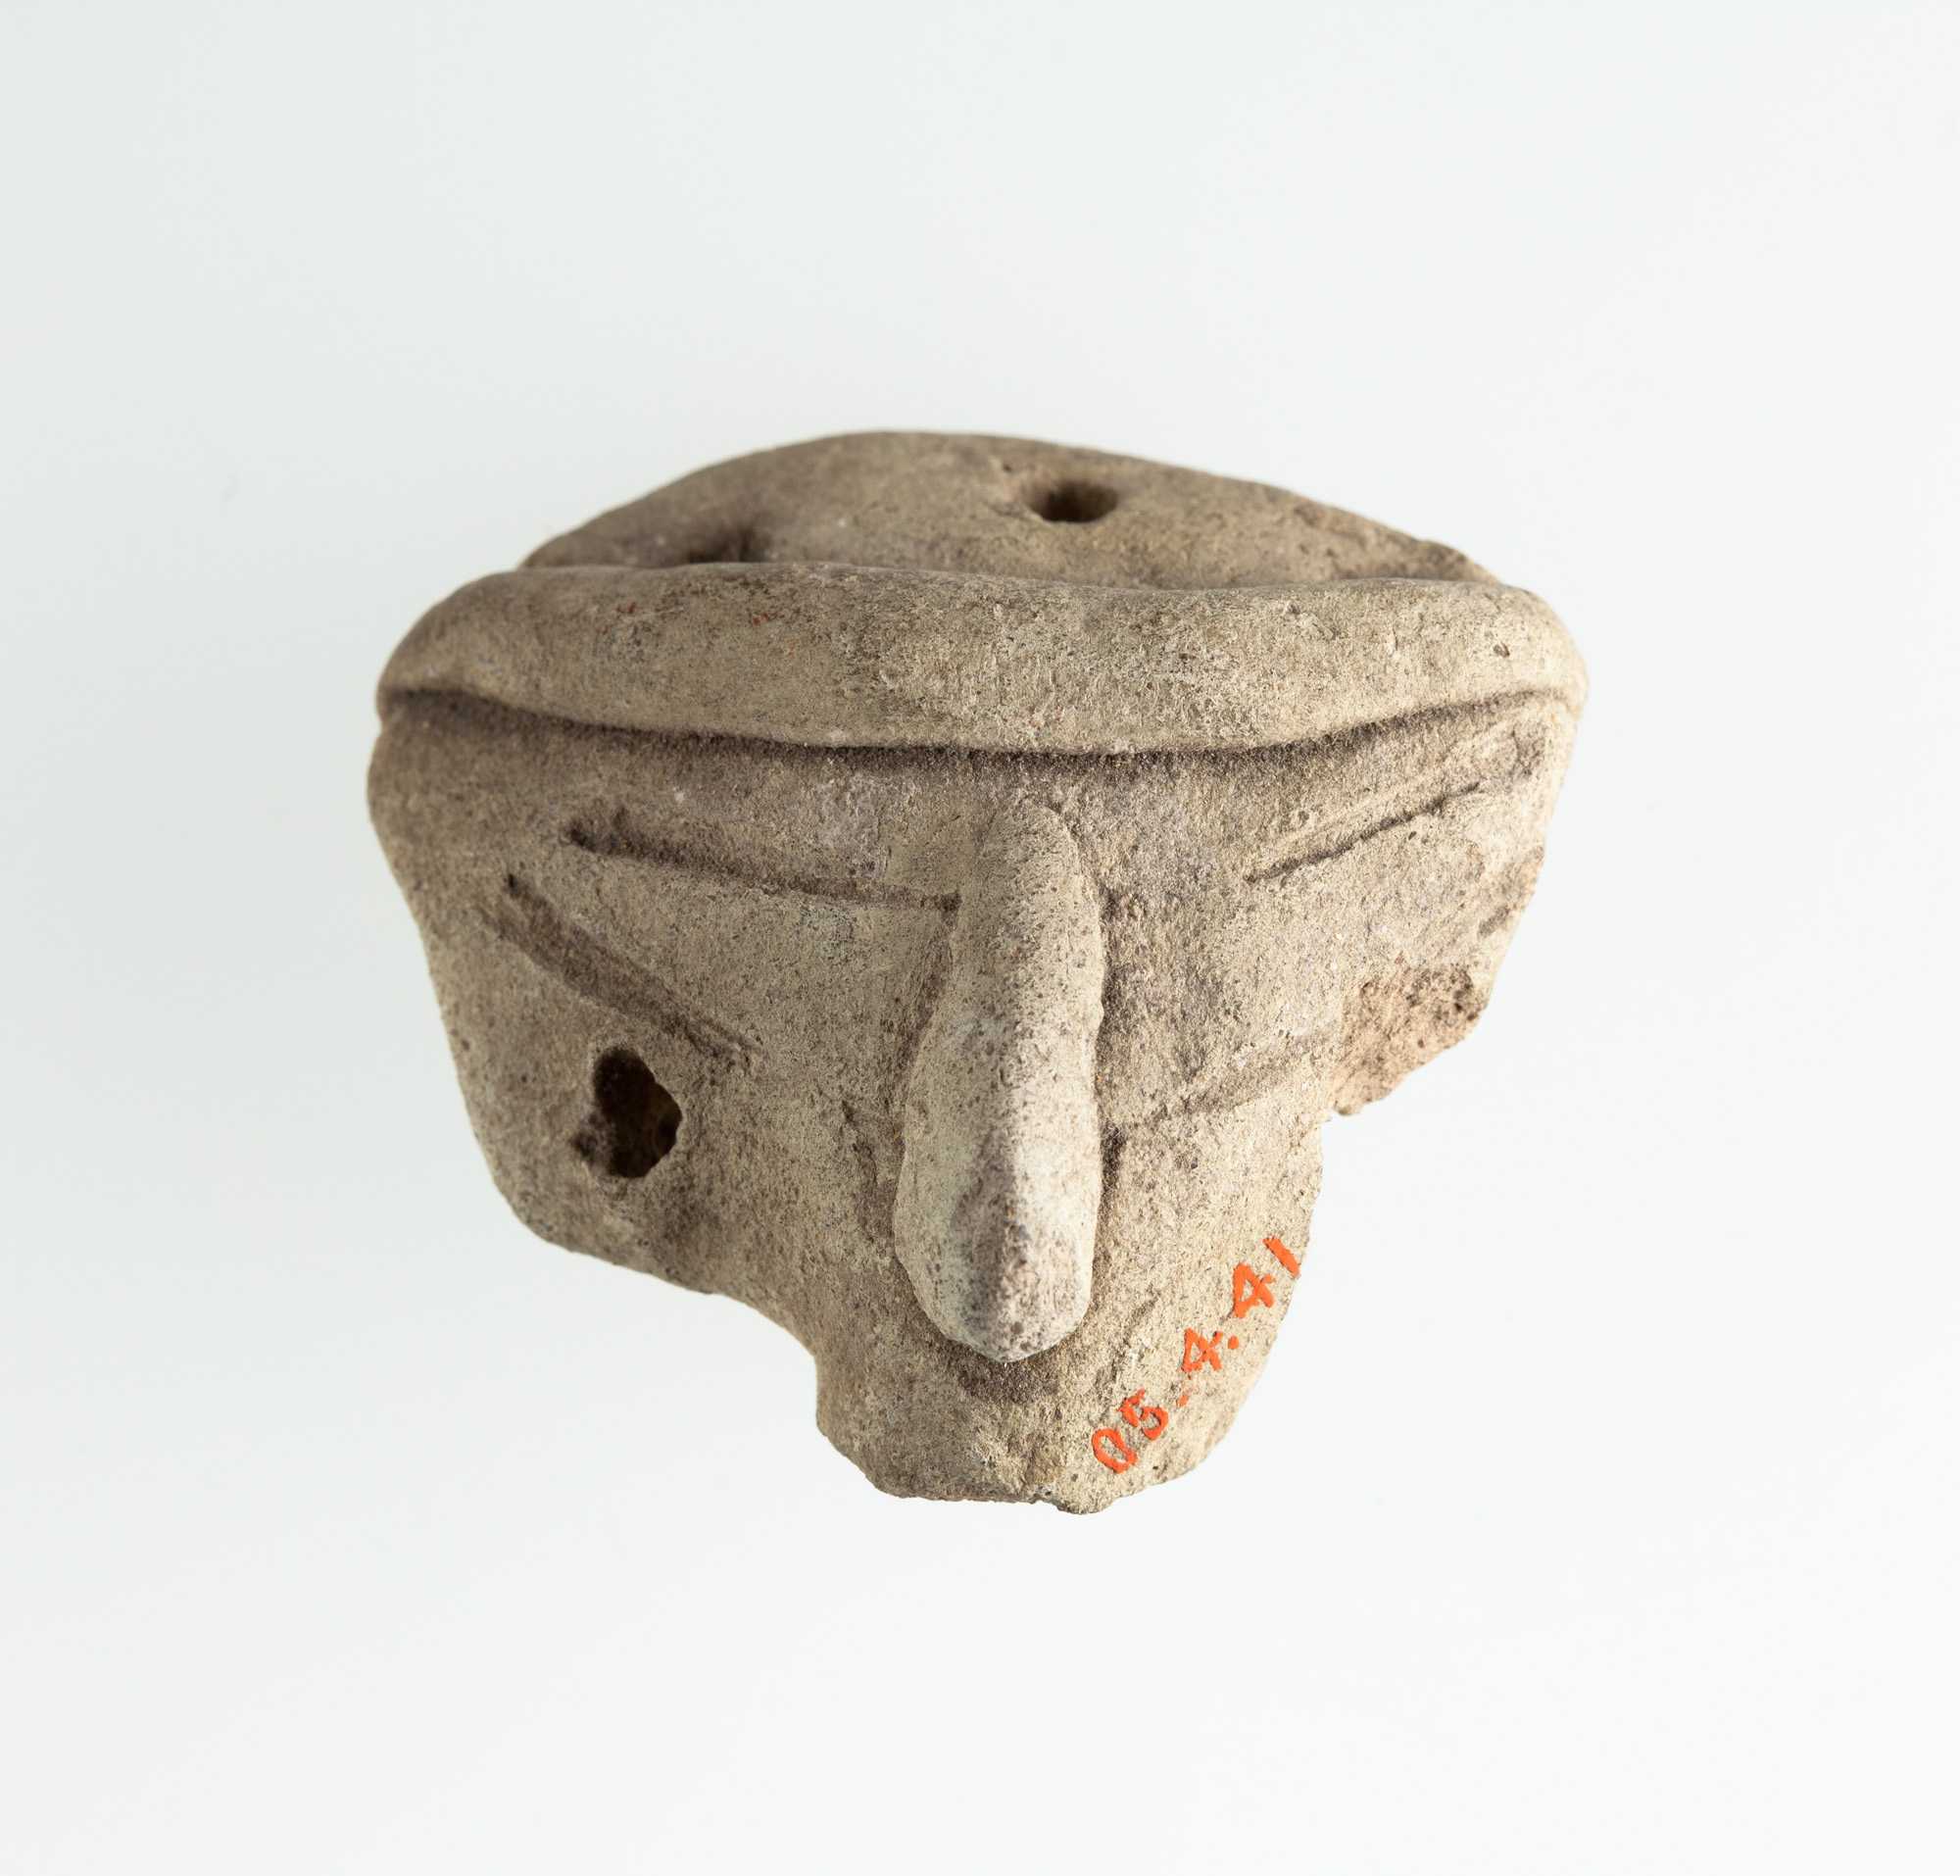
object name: amulet, hathor head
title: Votive Fragment, Hathor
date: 1479-1458 BCE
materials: faience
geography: egypt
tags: hathor